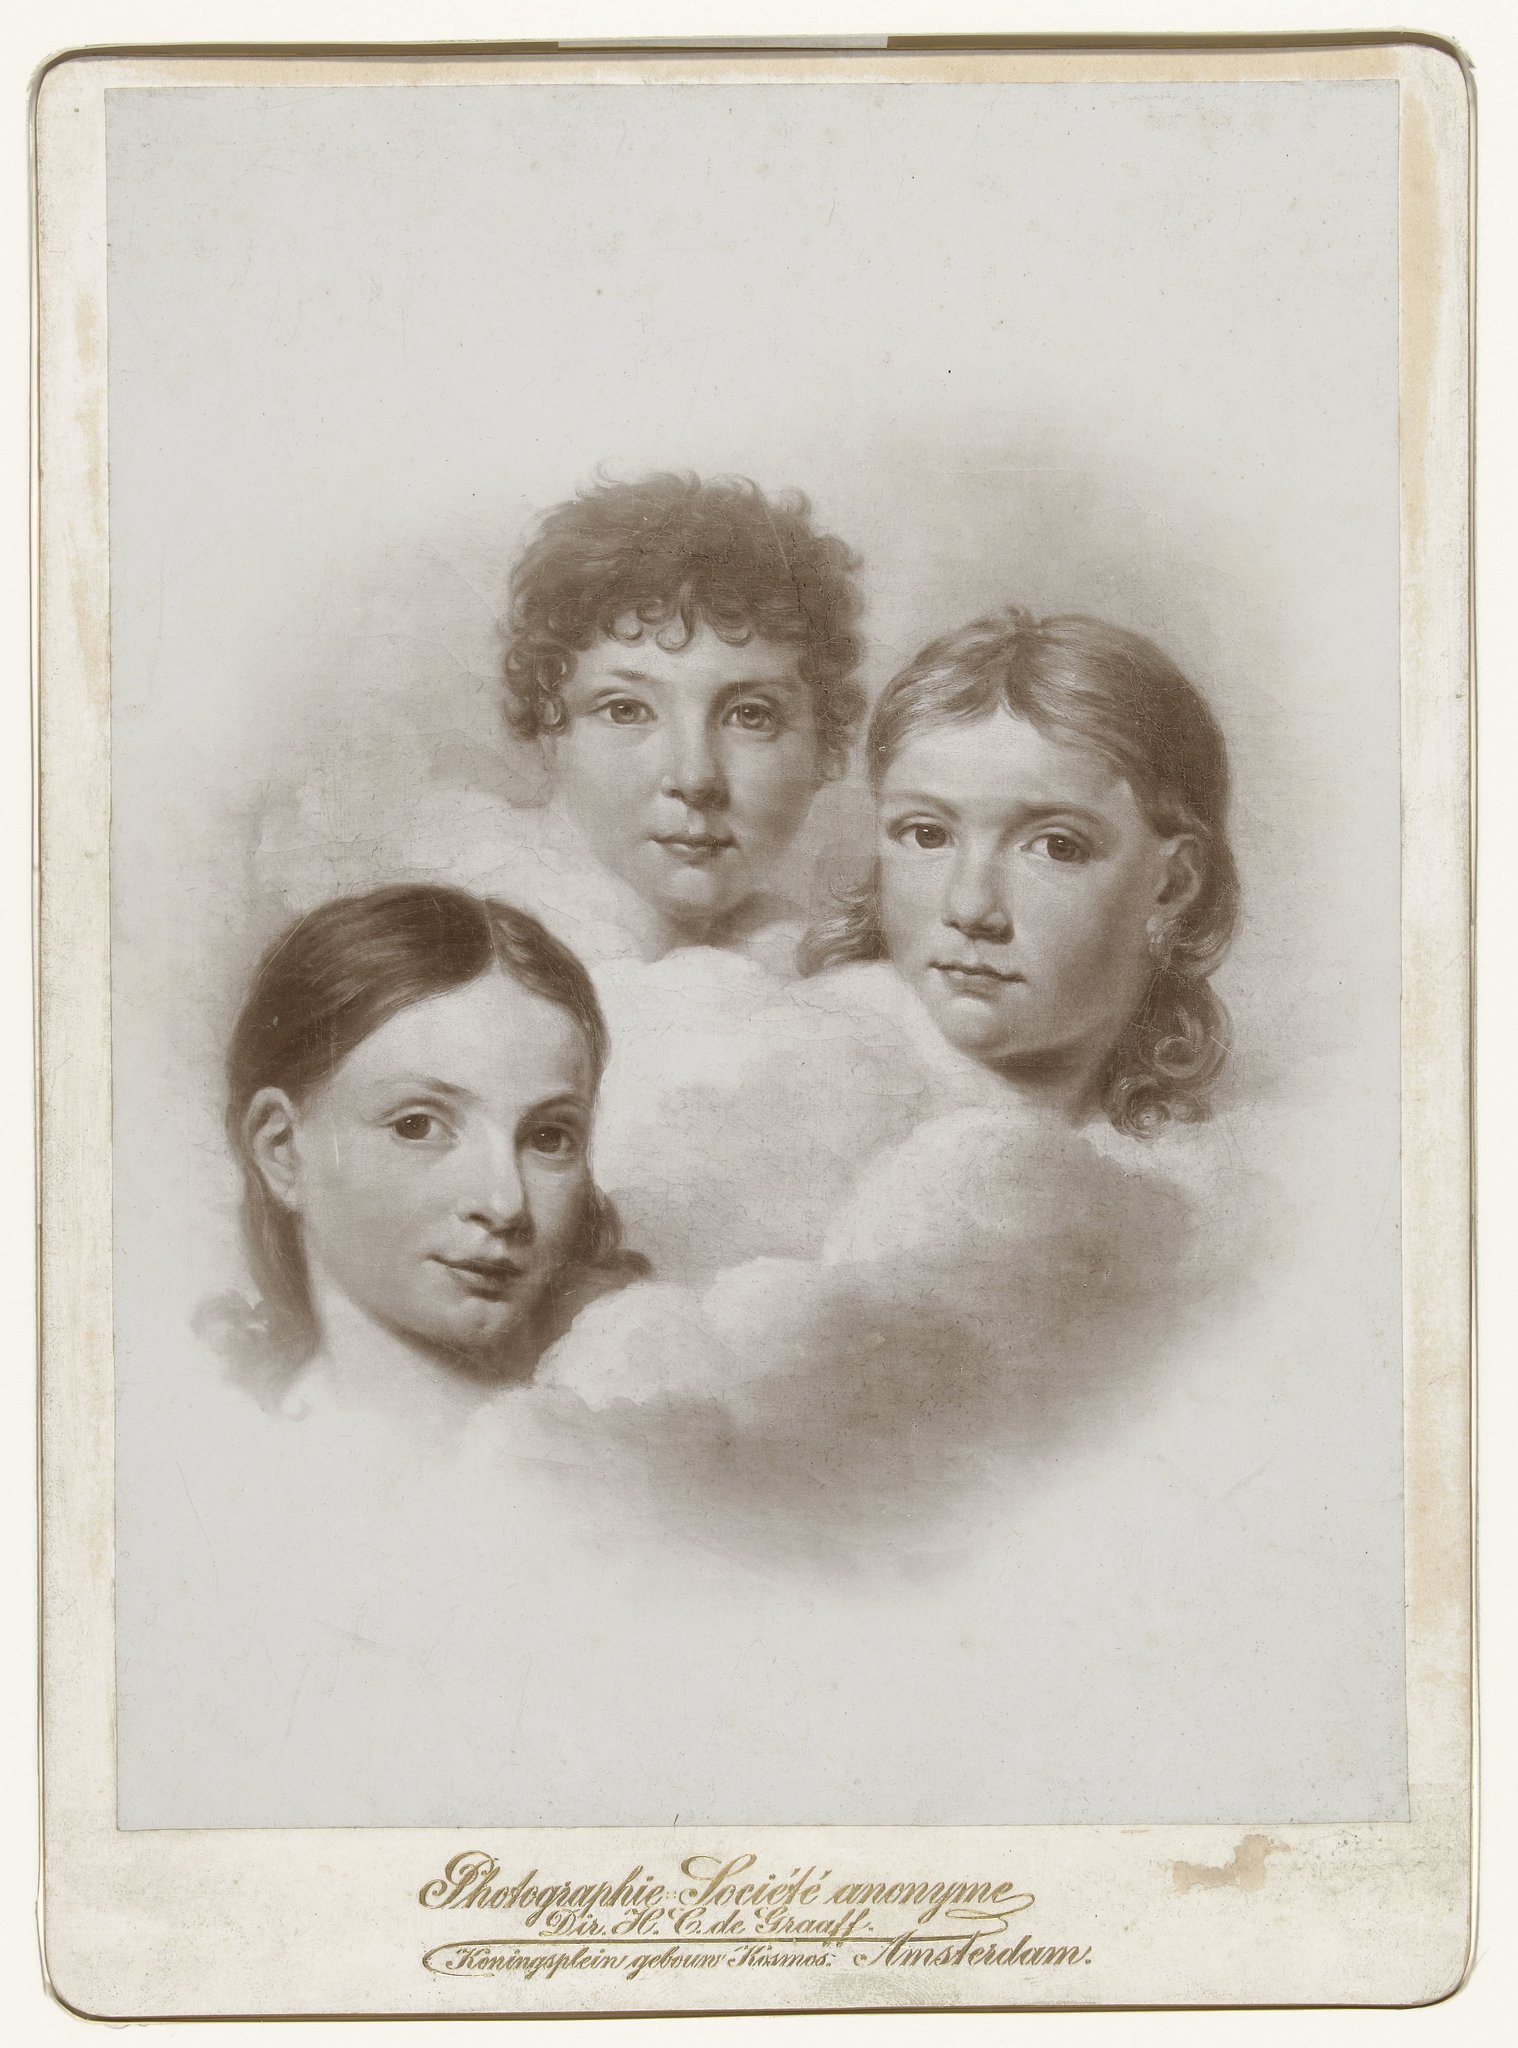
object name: photograph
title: Fotoreproductie van een schilderij: drie kinderportretjes in de wolken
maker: h.c. de graaff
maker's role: fotograaf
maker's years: 1853-1932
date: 1880-1920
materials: cardboard, paper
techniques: gelatin silver print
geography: amsterdam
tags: anonymous historical persons portrayed in a group, in a group-portrait, netherlands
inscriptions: check stamp: ‘Photographie Societe anonyme, Dhr. H. C. de Graaff Koningsplein gebouw Kosmos Amsterdam’